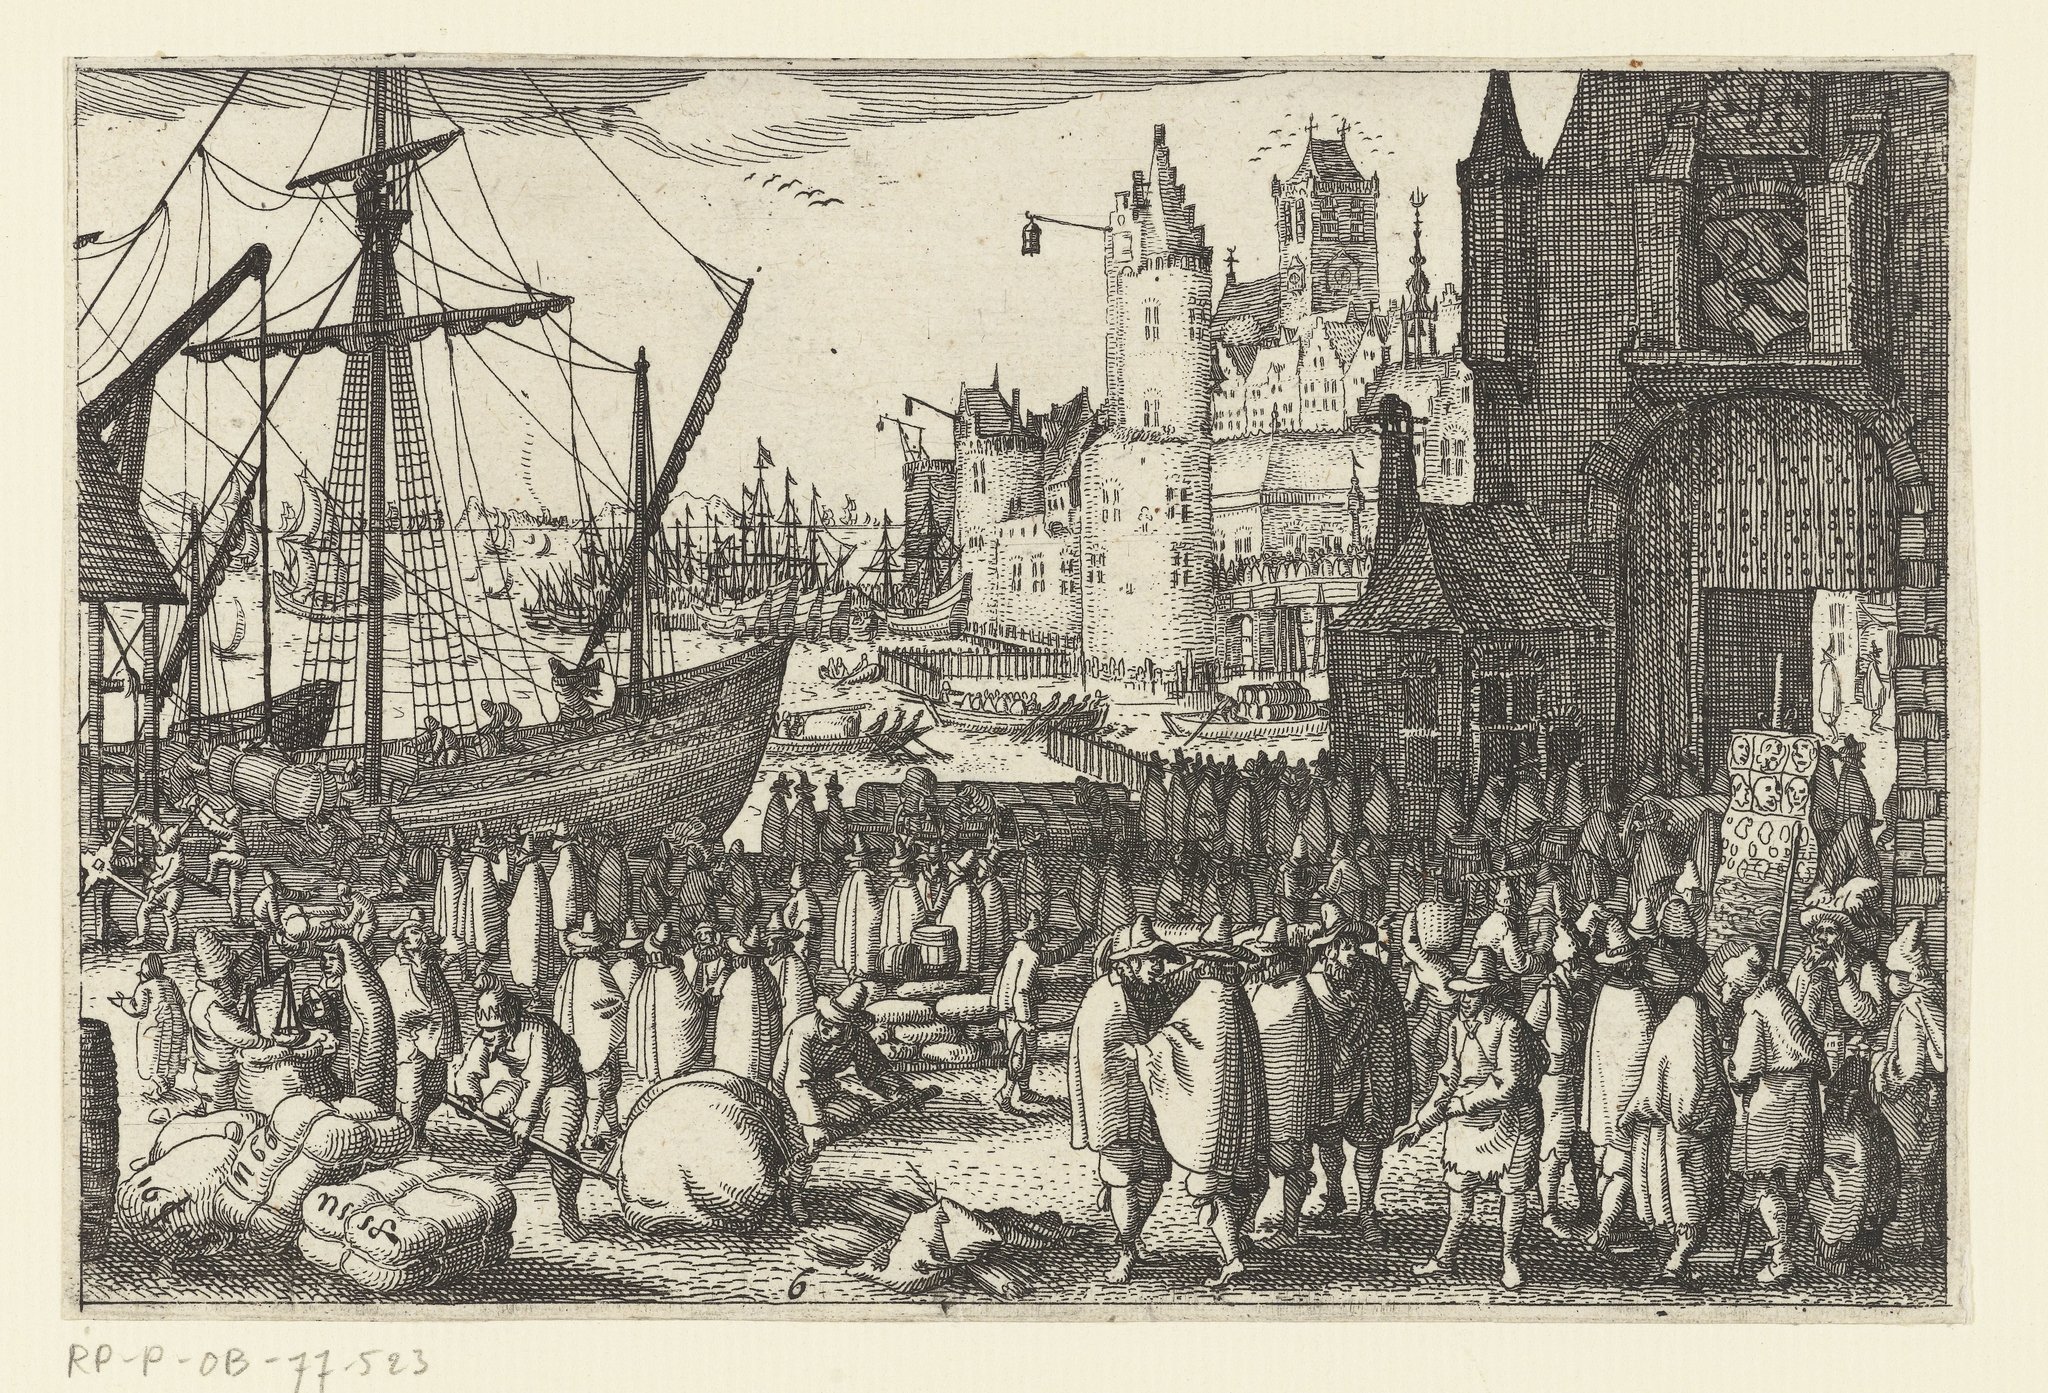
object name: print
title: Beroepen in Noord-Holland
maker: claes jansz. visscher (ii)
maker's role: draughtsman, print maker, publisher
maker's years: 1586-1652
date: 1608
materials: paper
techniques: etching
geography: northern netherlands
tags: harbour, locations for trading, persons engaged in trade and commerce, merchant shipping, shipping trade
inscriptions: date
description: Handel en koopvaardij, ca. 1600. Gezicht in een havenstad, rechts een stadspoort. Links wordt een schip gelost. Op de kade vol tonnen en balen wordt handelswaar gewogen en versjouwd en staan mannen in mantel en hoed met elkaar te praten. No. 6 uit serie beroepen in Noord-Holland.